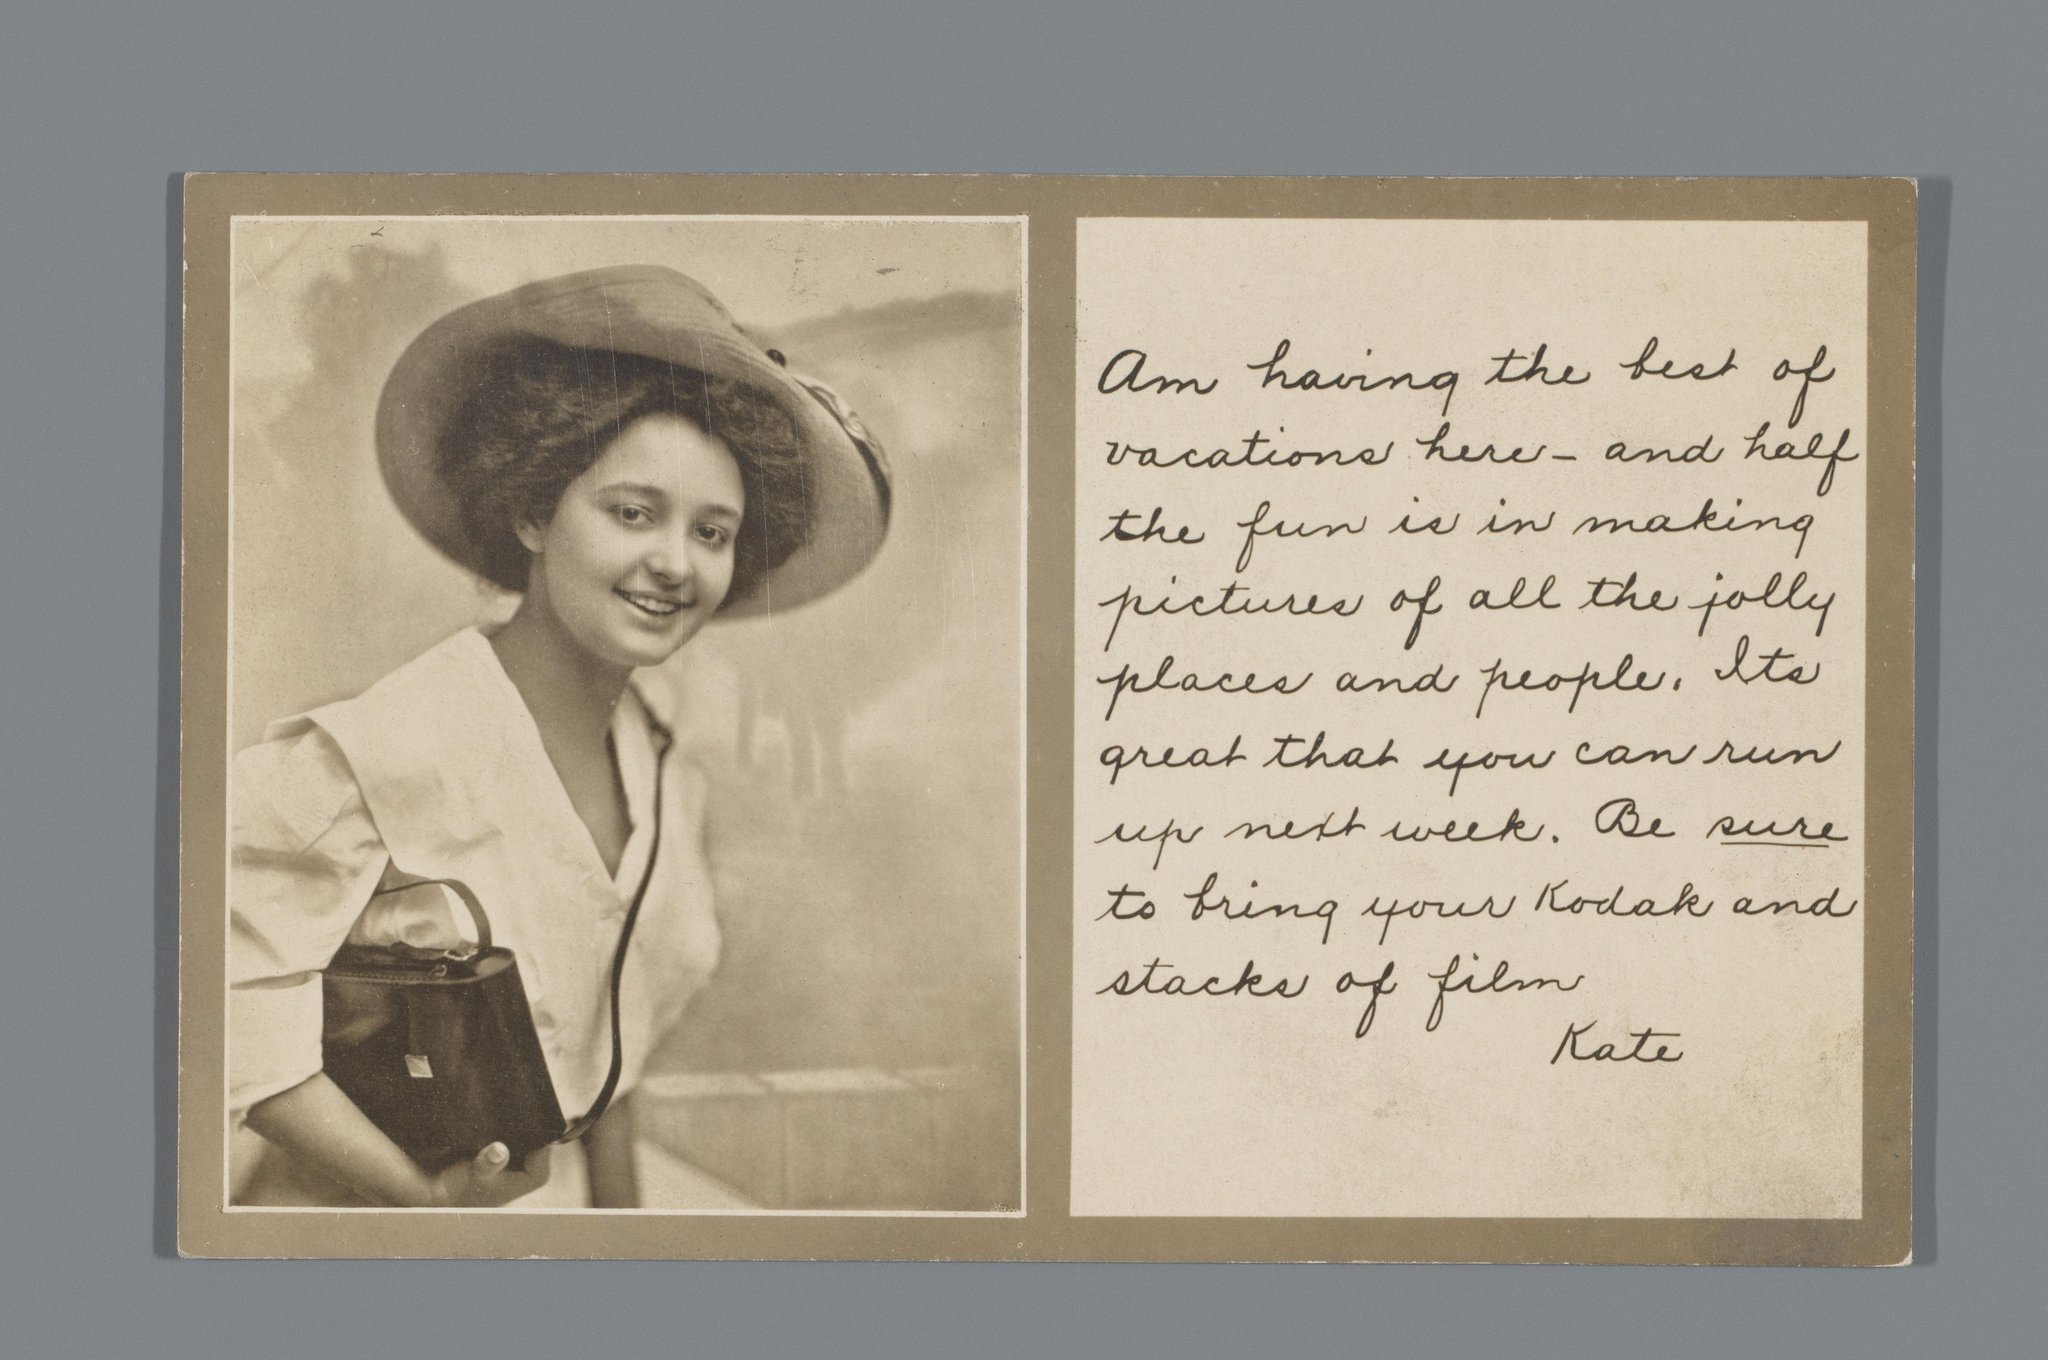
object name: ansichtkaart, prentbriefkaart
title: Reclame voor Kodak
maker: Anonymous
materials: photographic support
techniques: gelatin silver print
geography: united states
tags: publisher, united states of america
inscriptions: inscription, stamp: ‘1910’, inscription: ‘Am having the best of / vacations here – and half / the fun is in making / pictures of all the jolly / places and people. Its / great that you can run / up next week. Be sure / to bring your Kodak and / stacks of film / Kate’